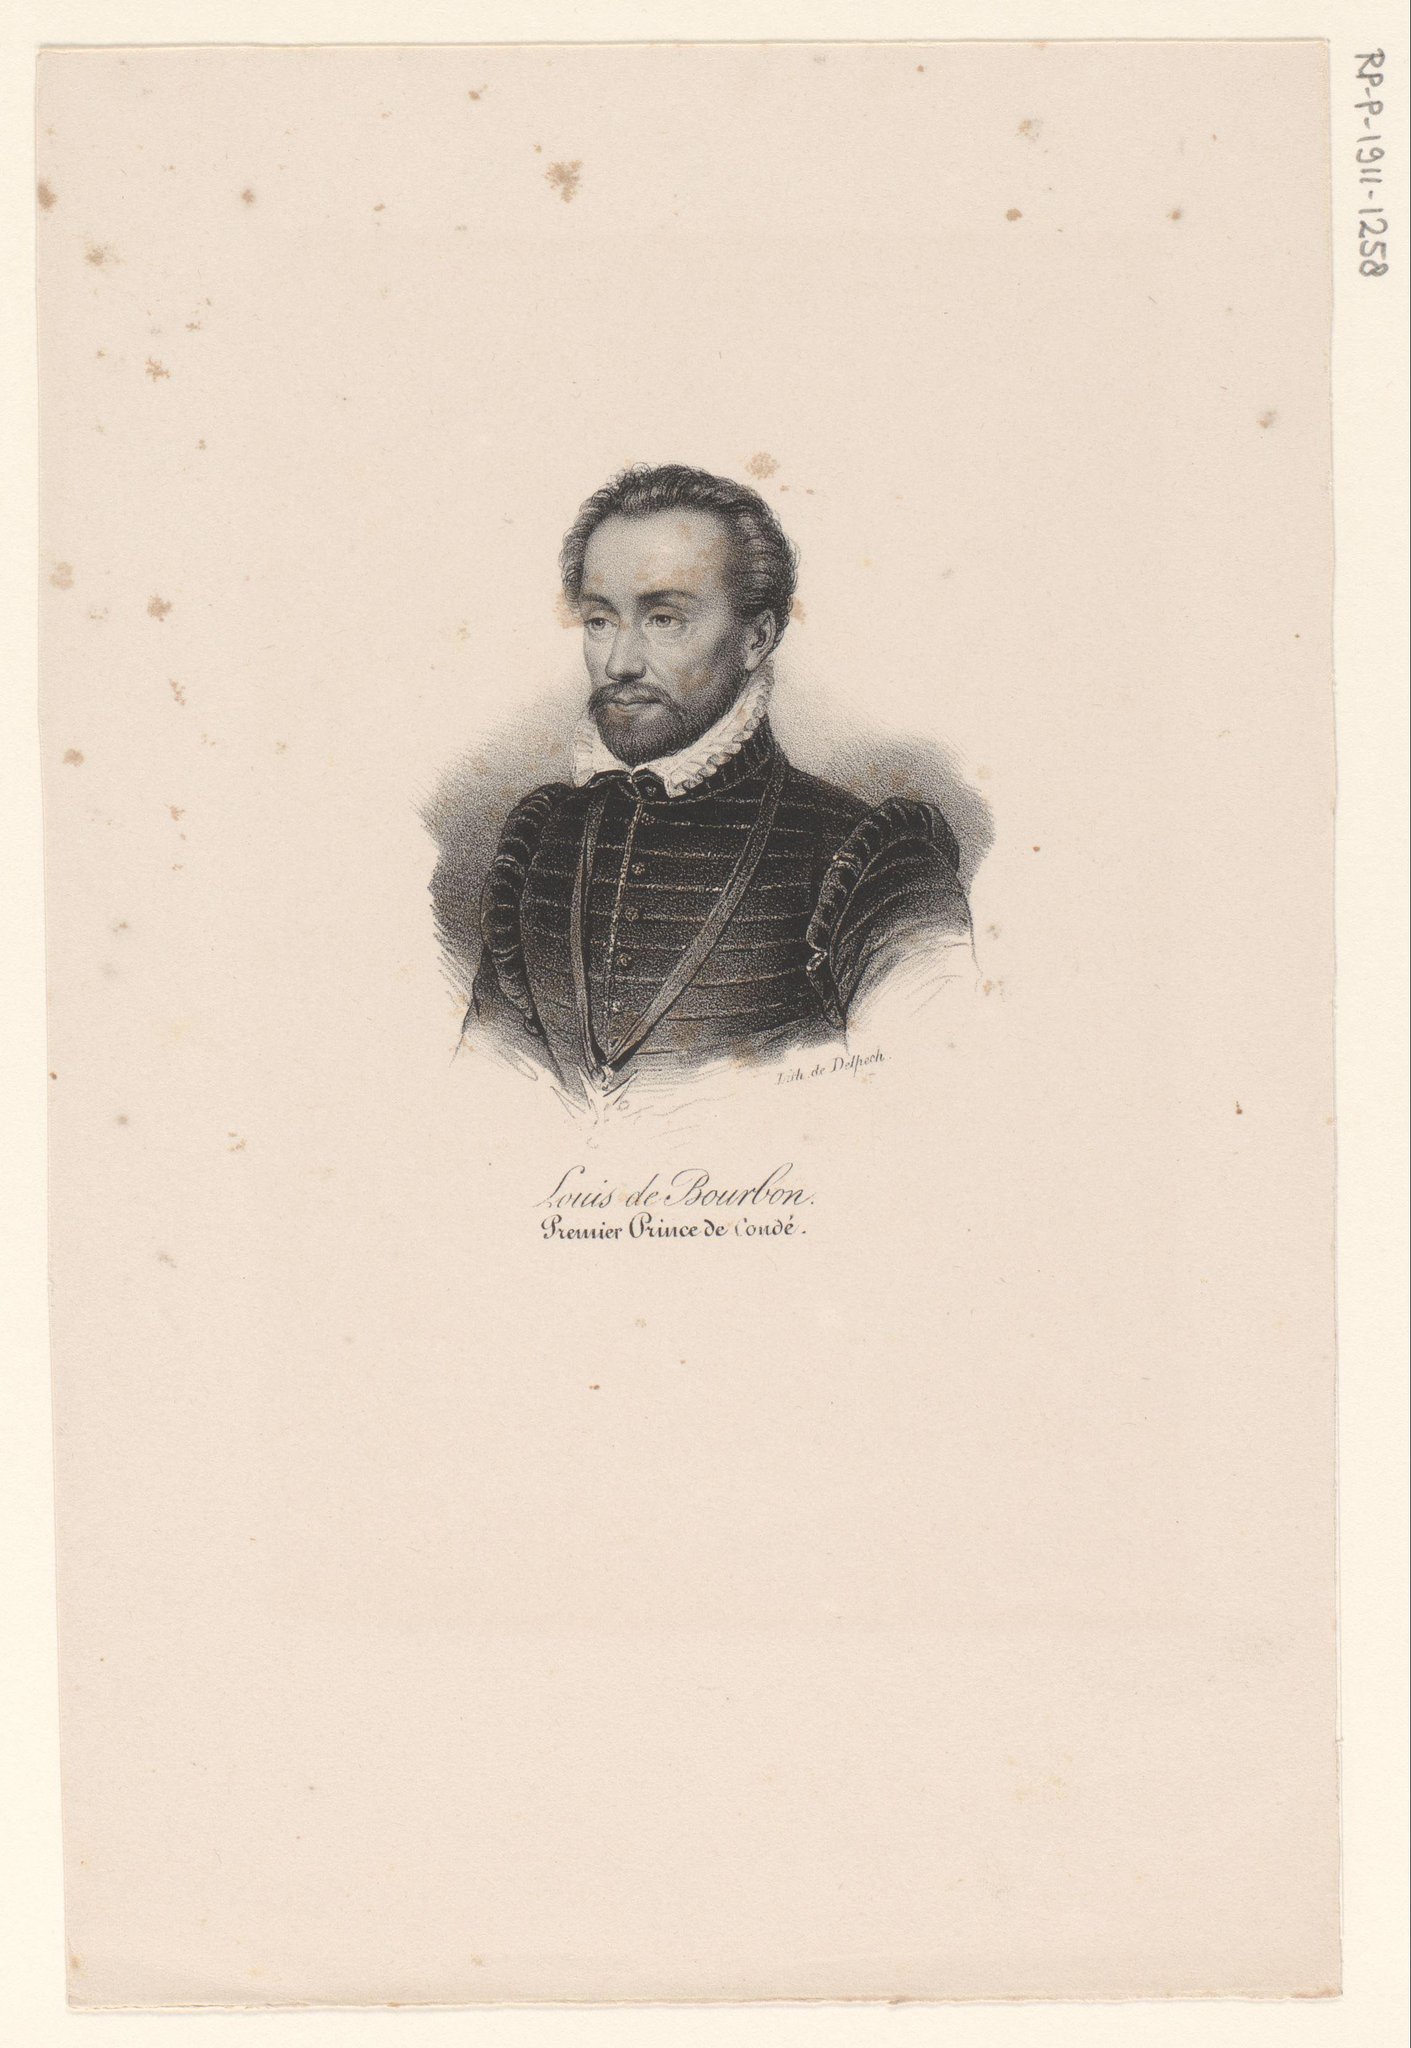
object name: print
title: Portret van Lodewijk I van Bourbon-Condé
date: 1818-1842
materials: paper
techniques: lithograph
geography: paris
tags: historical persons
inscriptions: collector's mark: Lugt 2228a